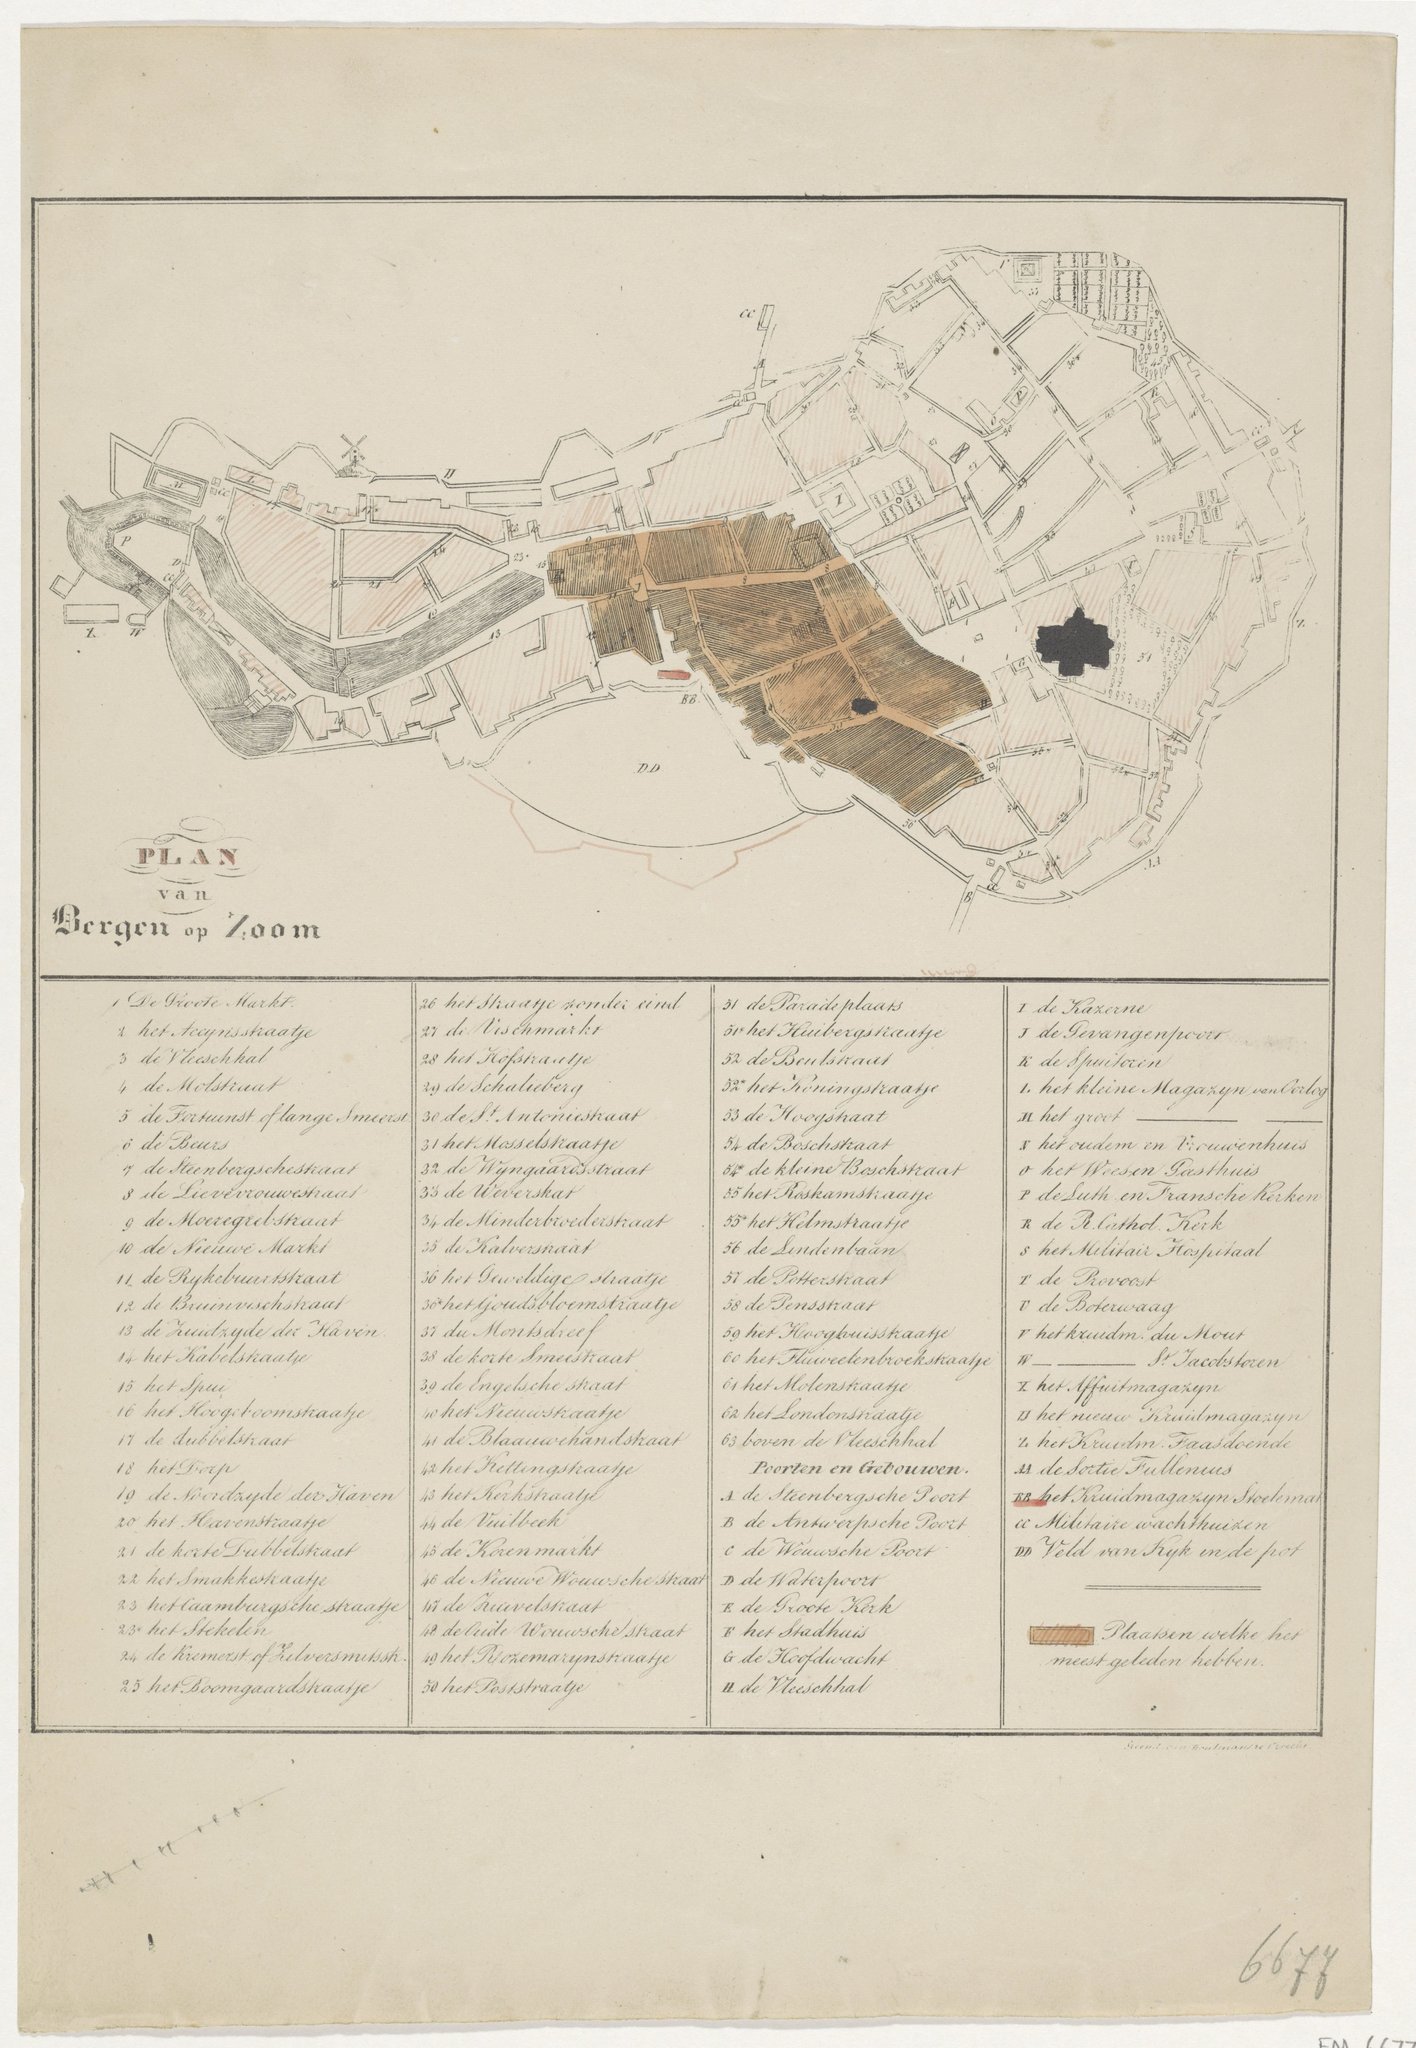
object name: print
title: Plan van Bergen op Zoom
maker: johannes paulus houtman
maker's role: bookseller, print maker, printer, publisher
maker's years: 1803-1845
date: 1831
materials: paper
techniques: hand coloring, lithograph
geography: utrecht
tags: maps of cities, gunpowder disaster, bergen op zoom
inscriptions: collector's mark: Lugt 2228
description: Plattegrond van Bergen op Zooom waarop de schade is aangegeven aangericht door de ontploffing in de kruitmagazijn van laboratorium Stoelemat te Bergen op Zoom, 29 maart 1831. Delen van de kaart met kleuren aangegeven. Met in vier kolommen de legenda 1-63, A-Z en AA-DD.